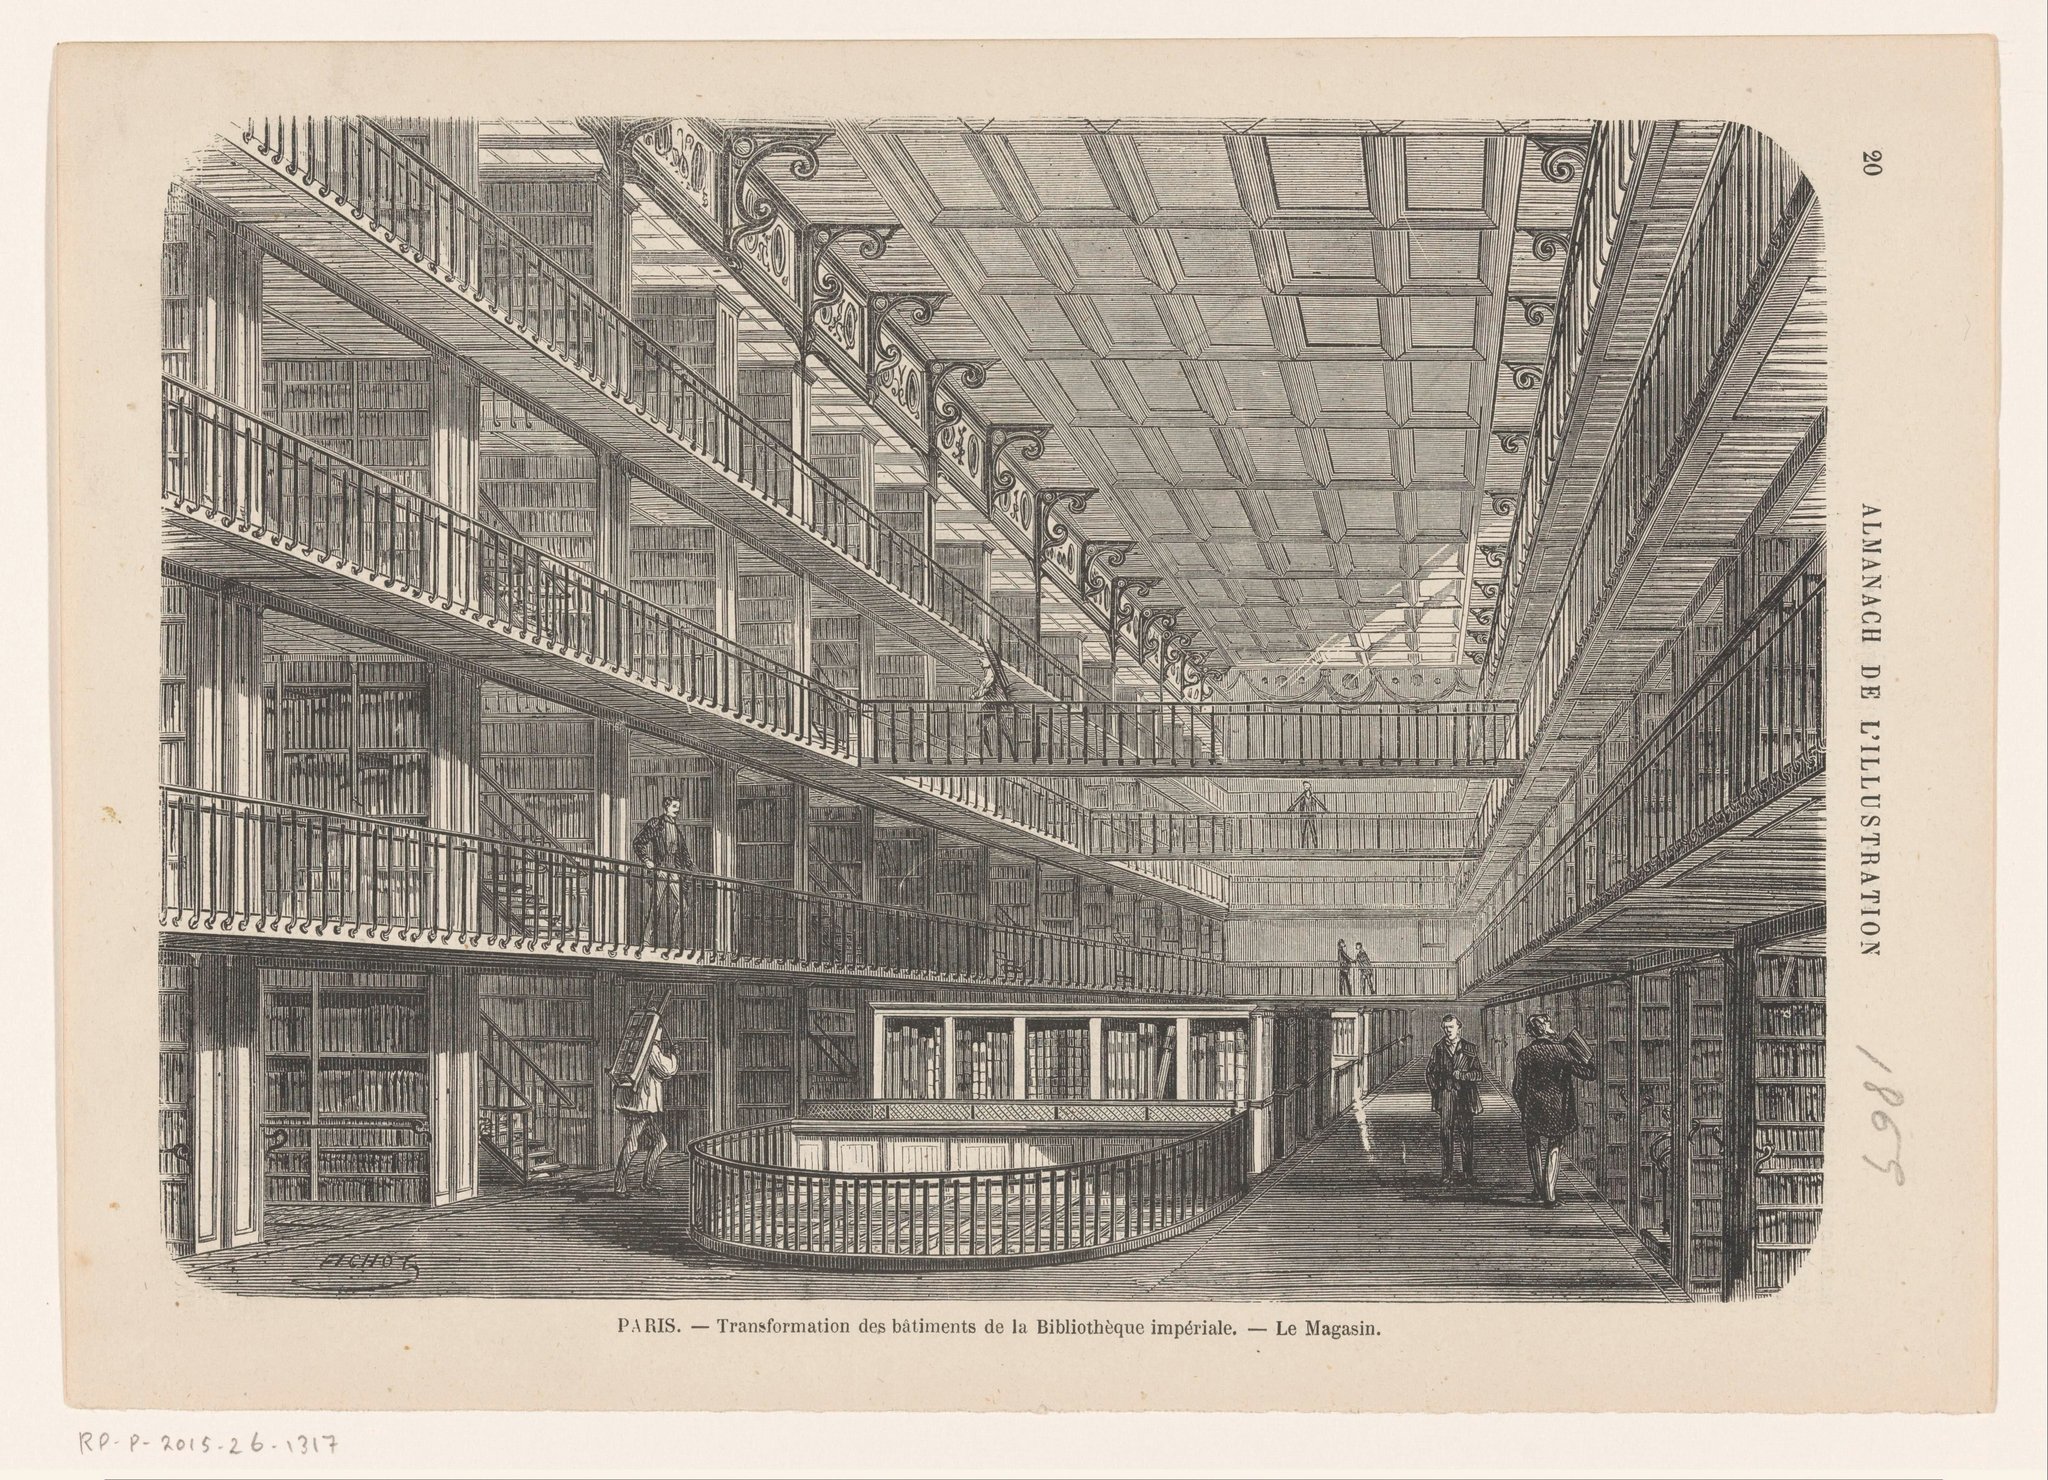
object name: illustration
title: Paris - Transformation des bâtiments de la Bibliothèque impériale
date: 1869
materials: paper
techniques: engraving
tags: porter, bearer, public library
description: Interieur van de Bibliothèque impériale vlak voor de verhuizing. Op de prent staan verschillende personen, onder wie twee dragers. Linksboven genummerd: 20.